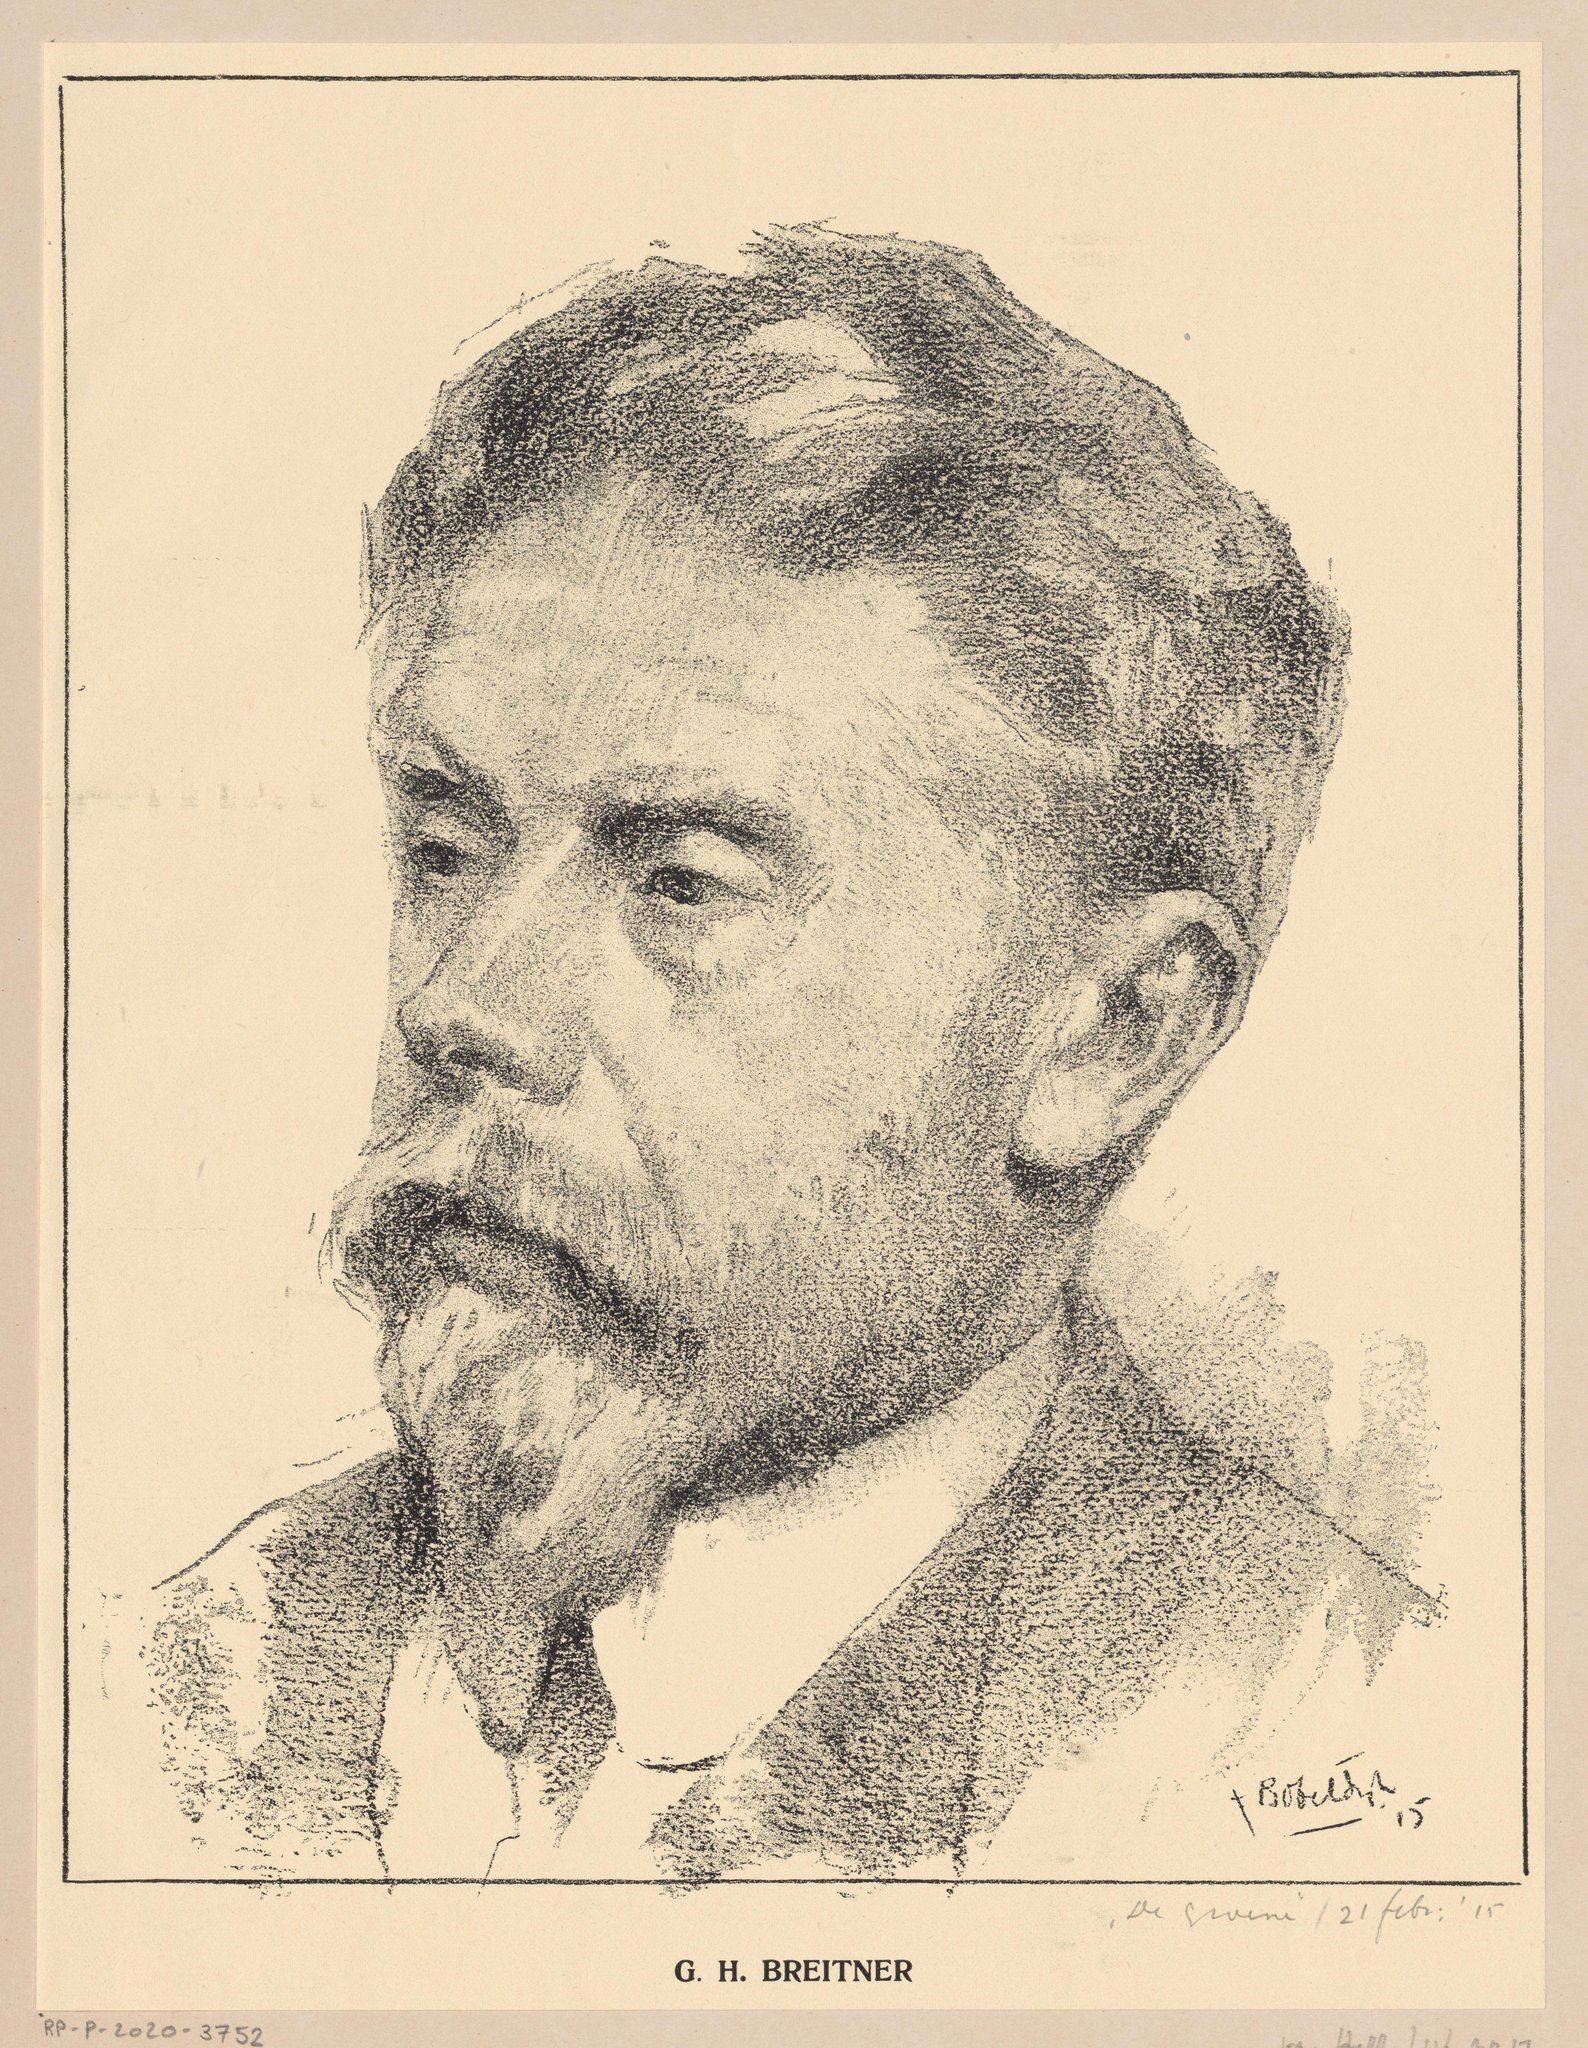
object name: photomechanical print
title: Portret van George Hendrik Breitner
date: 1915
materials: paper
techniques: printing block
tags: rotterdam, amsterdam, painter, print maker, draughtsman, george hendrik breitner, historical persons, portrait, self-portrait of painter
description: Prent uit: De Amsterdammer, nr. 1965, 21 februari 1915.